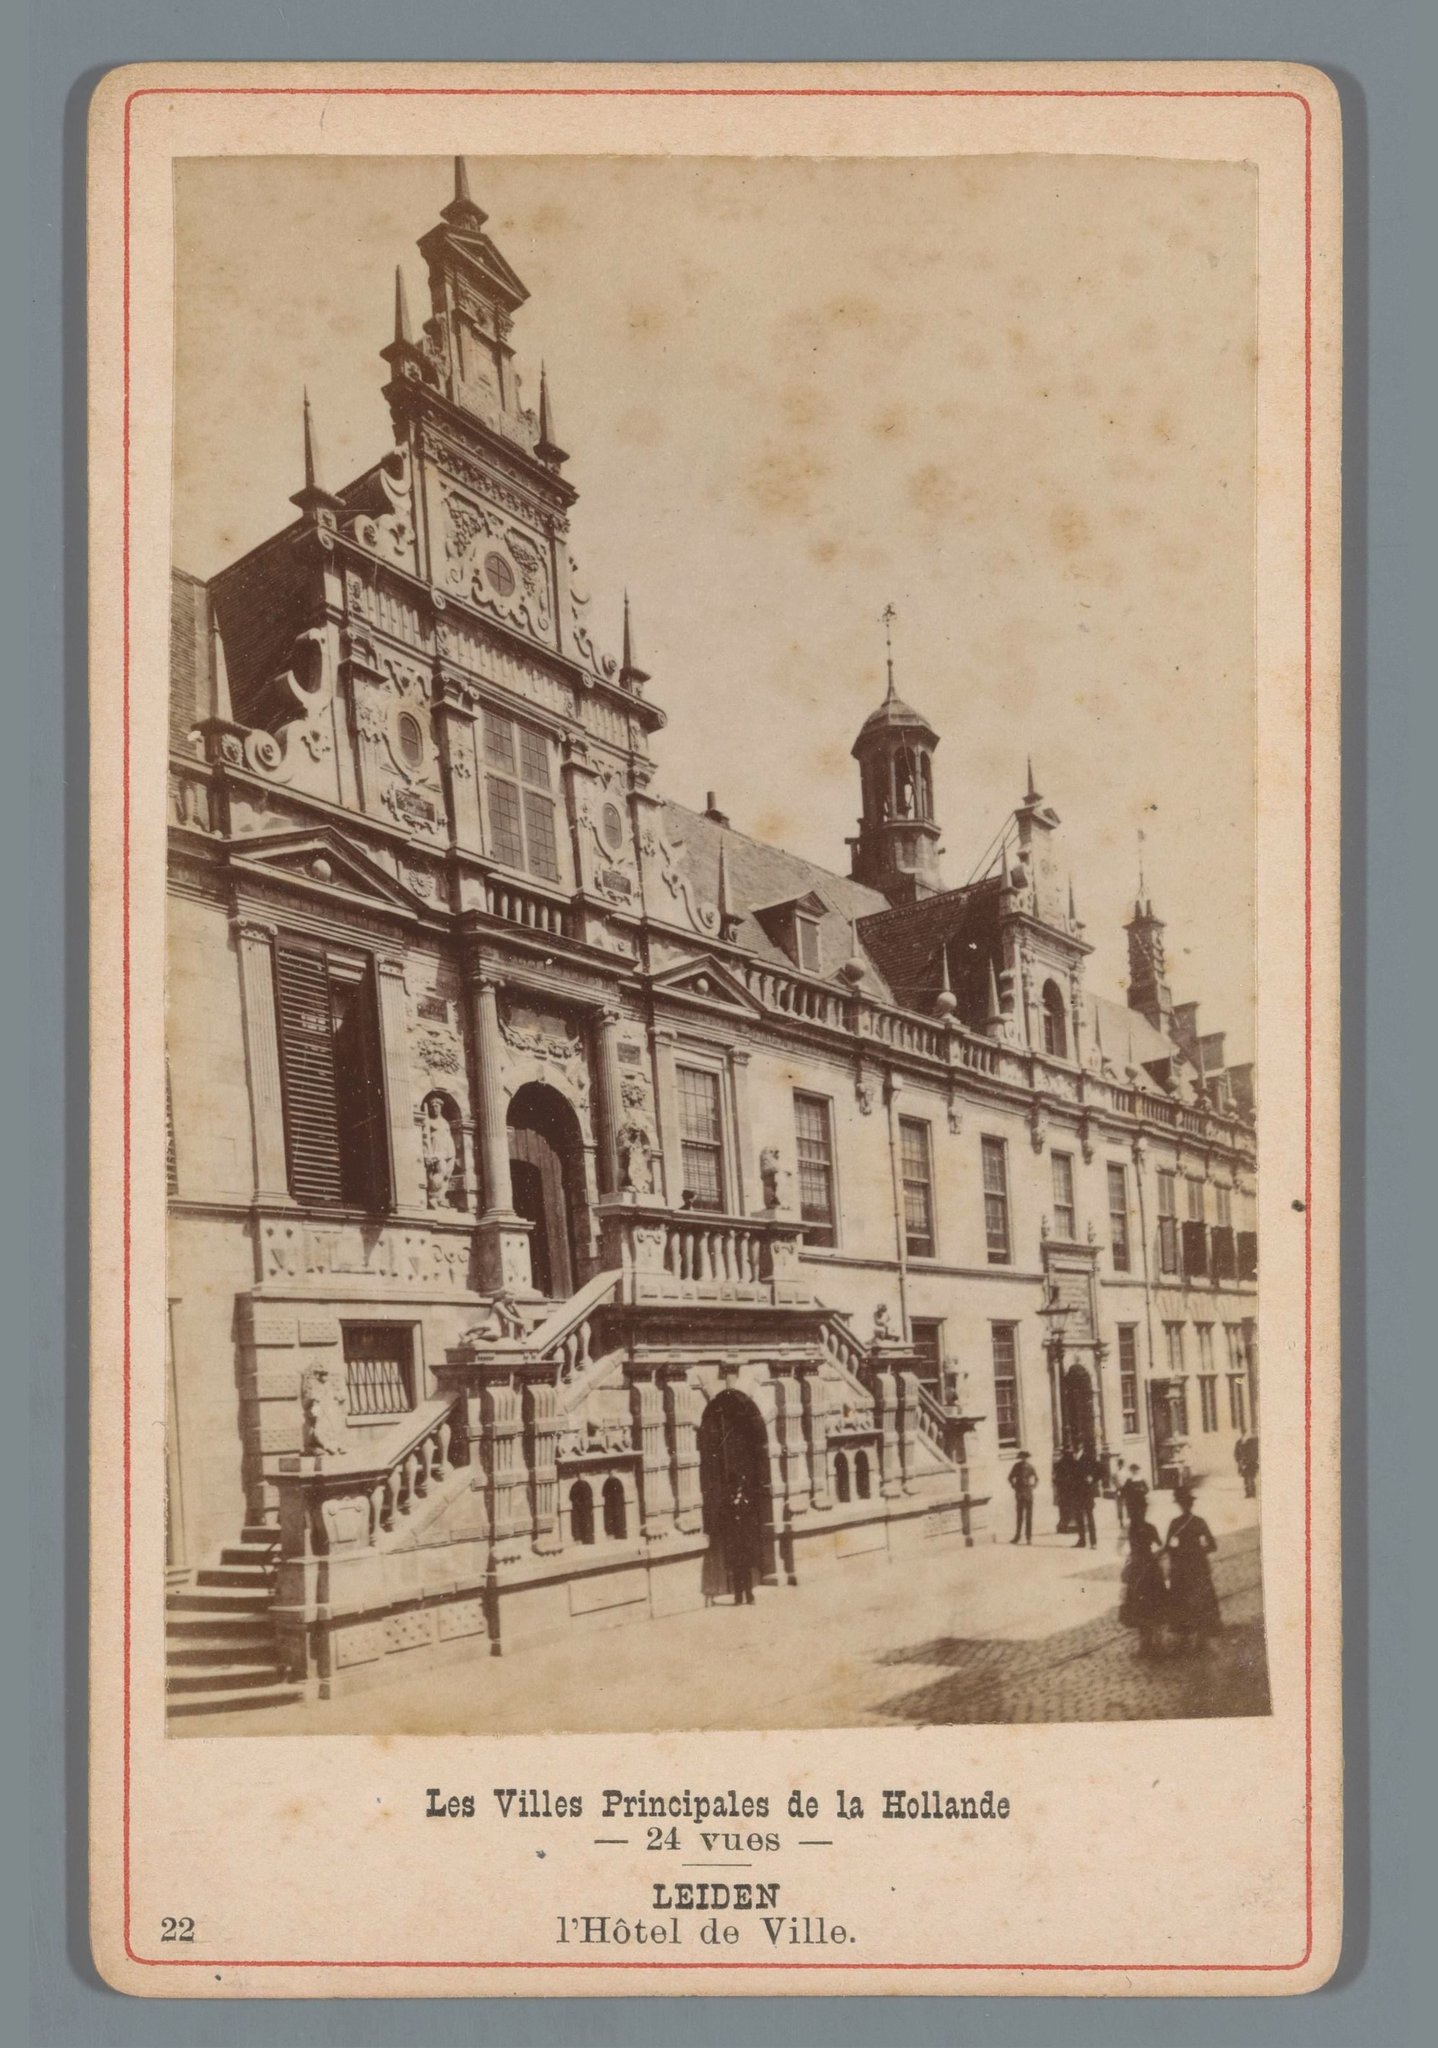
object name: photograph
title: Gezicht op het Stadhuis te Leiden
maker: Anonymous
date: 1850-1900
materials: cardboard, photographic support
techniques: albumen print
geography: leiden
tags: city-view in general; 'veduta', townhall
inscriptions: number: ‘22’